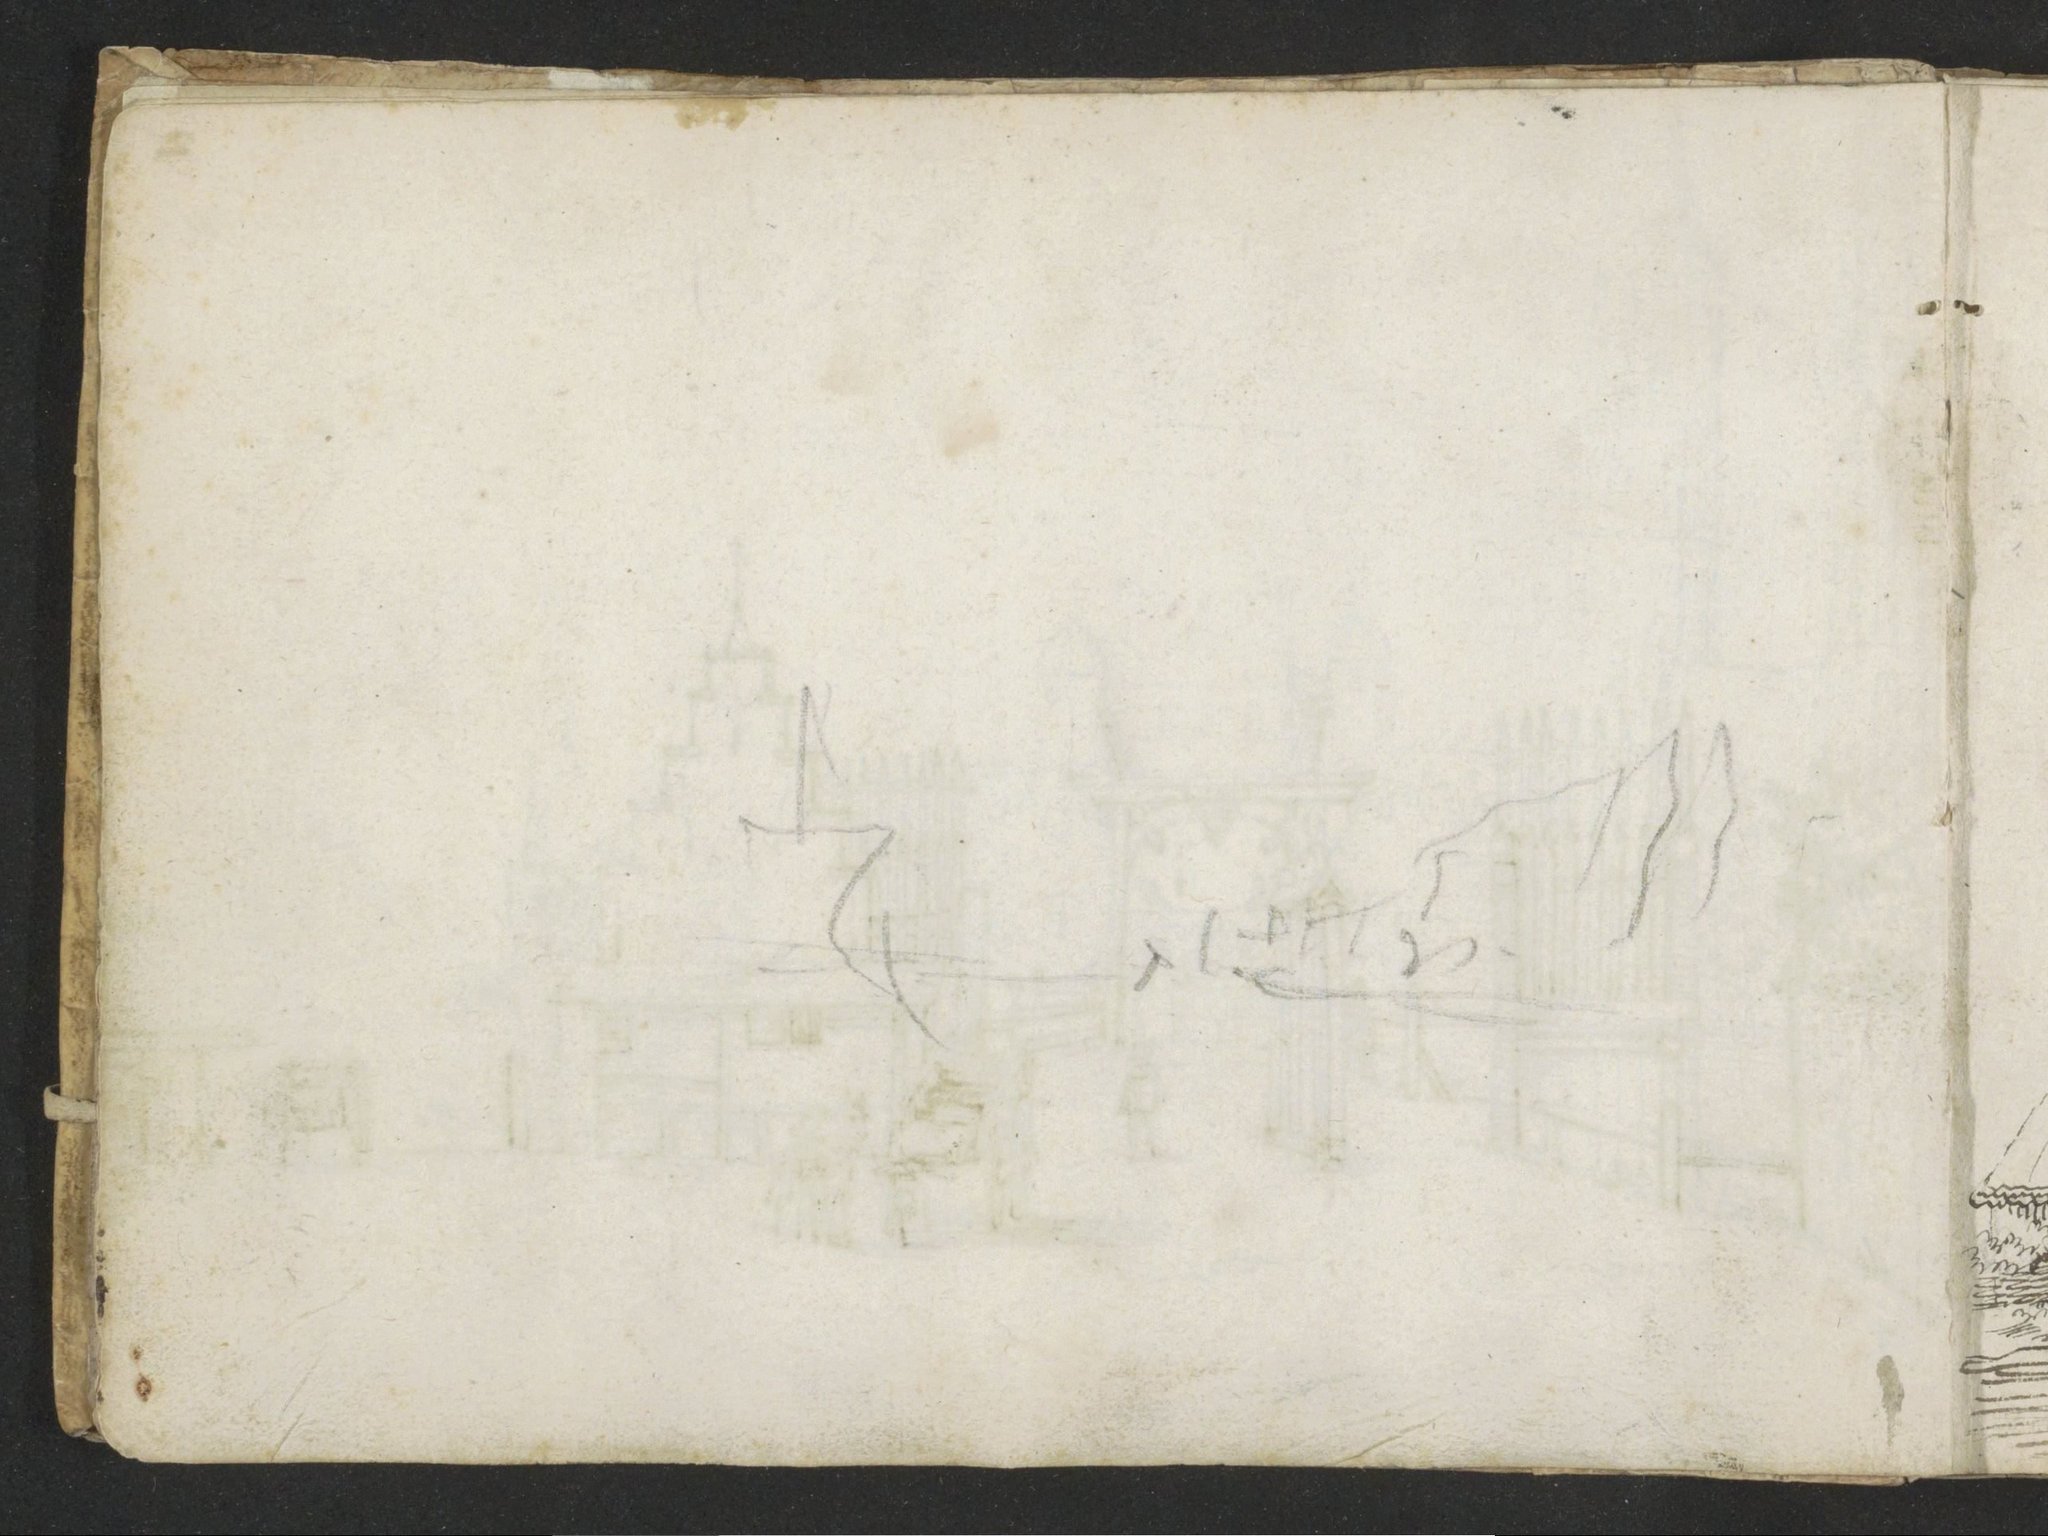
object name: sketchbook leaf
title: Studie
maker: gerard ter borch (ii)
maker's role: draughtsman, painter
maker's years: 1617-1681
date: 1631-1633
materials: paper, pencil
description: Vermoedelijk een stadsgezicht. Blad 2 verso uit een schetsboek met 55 bladen.